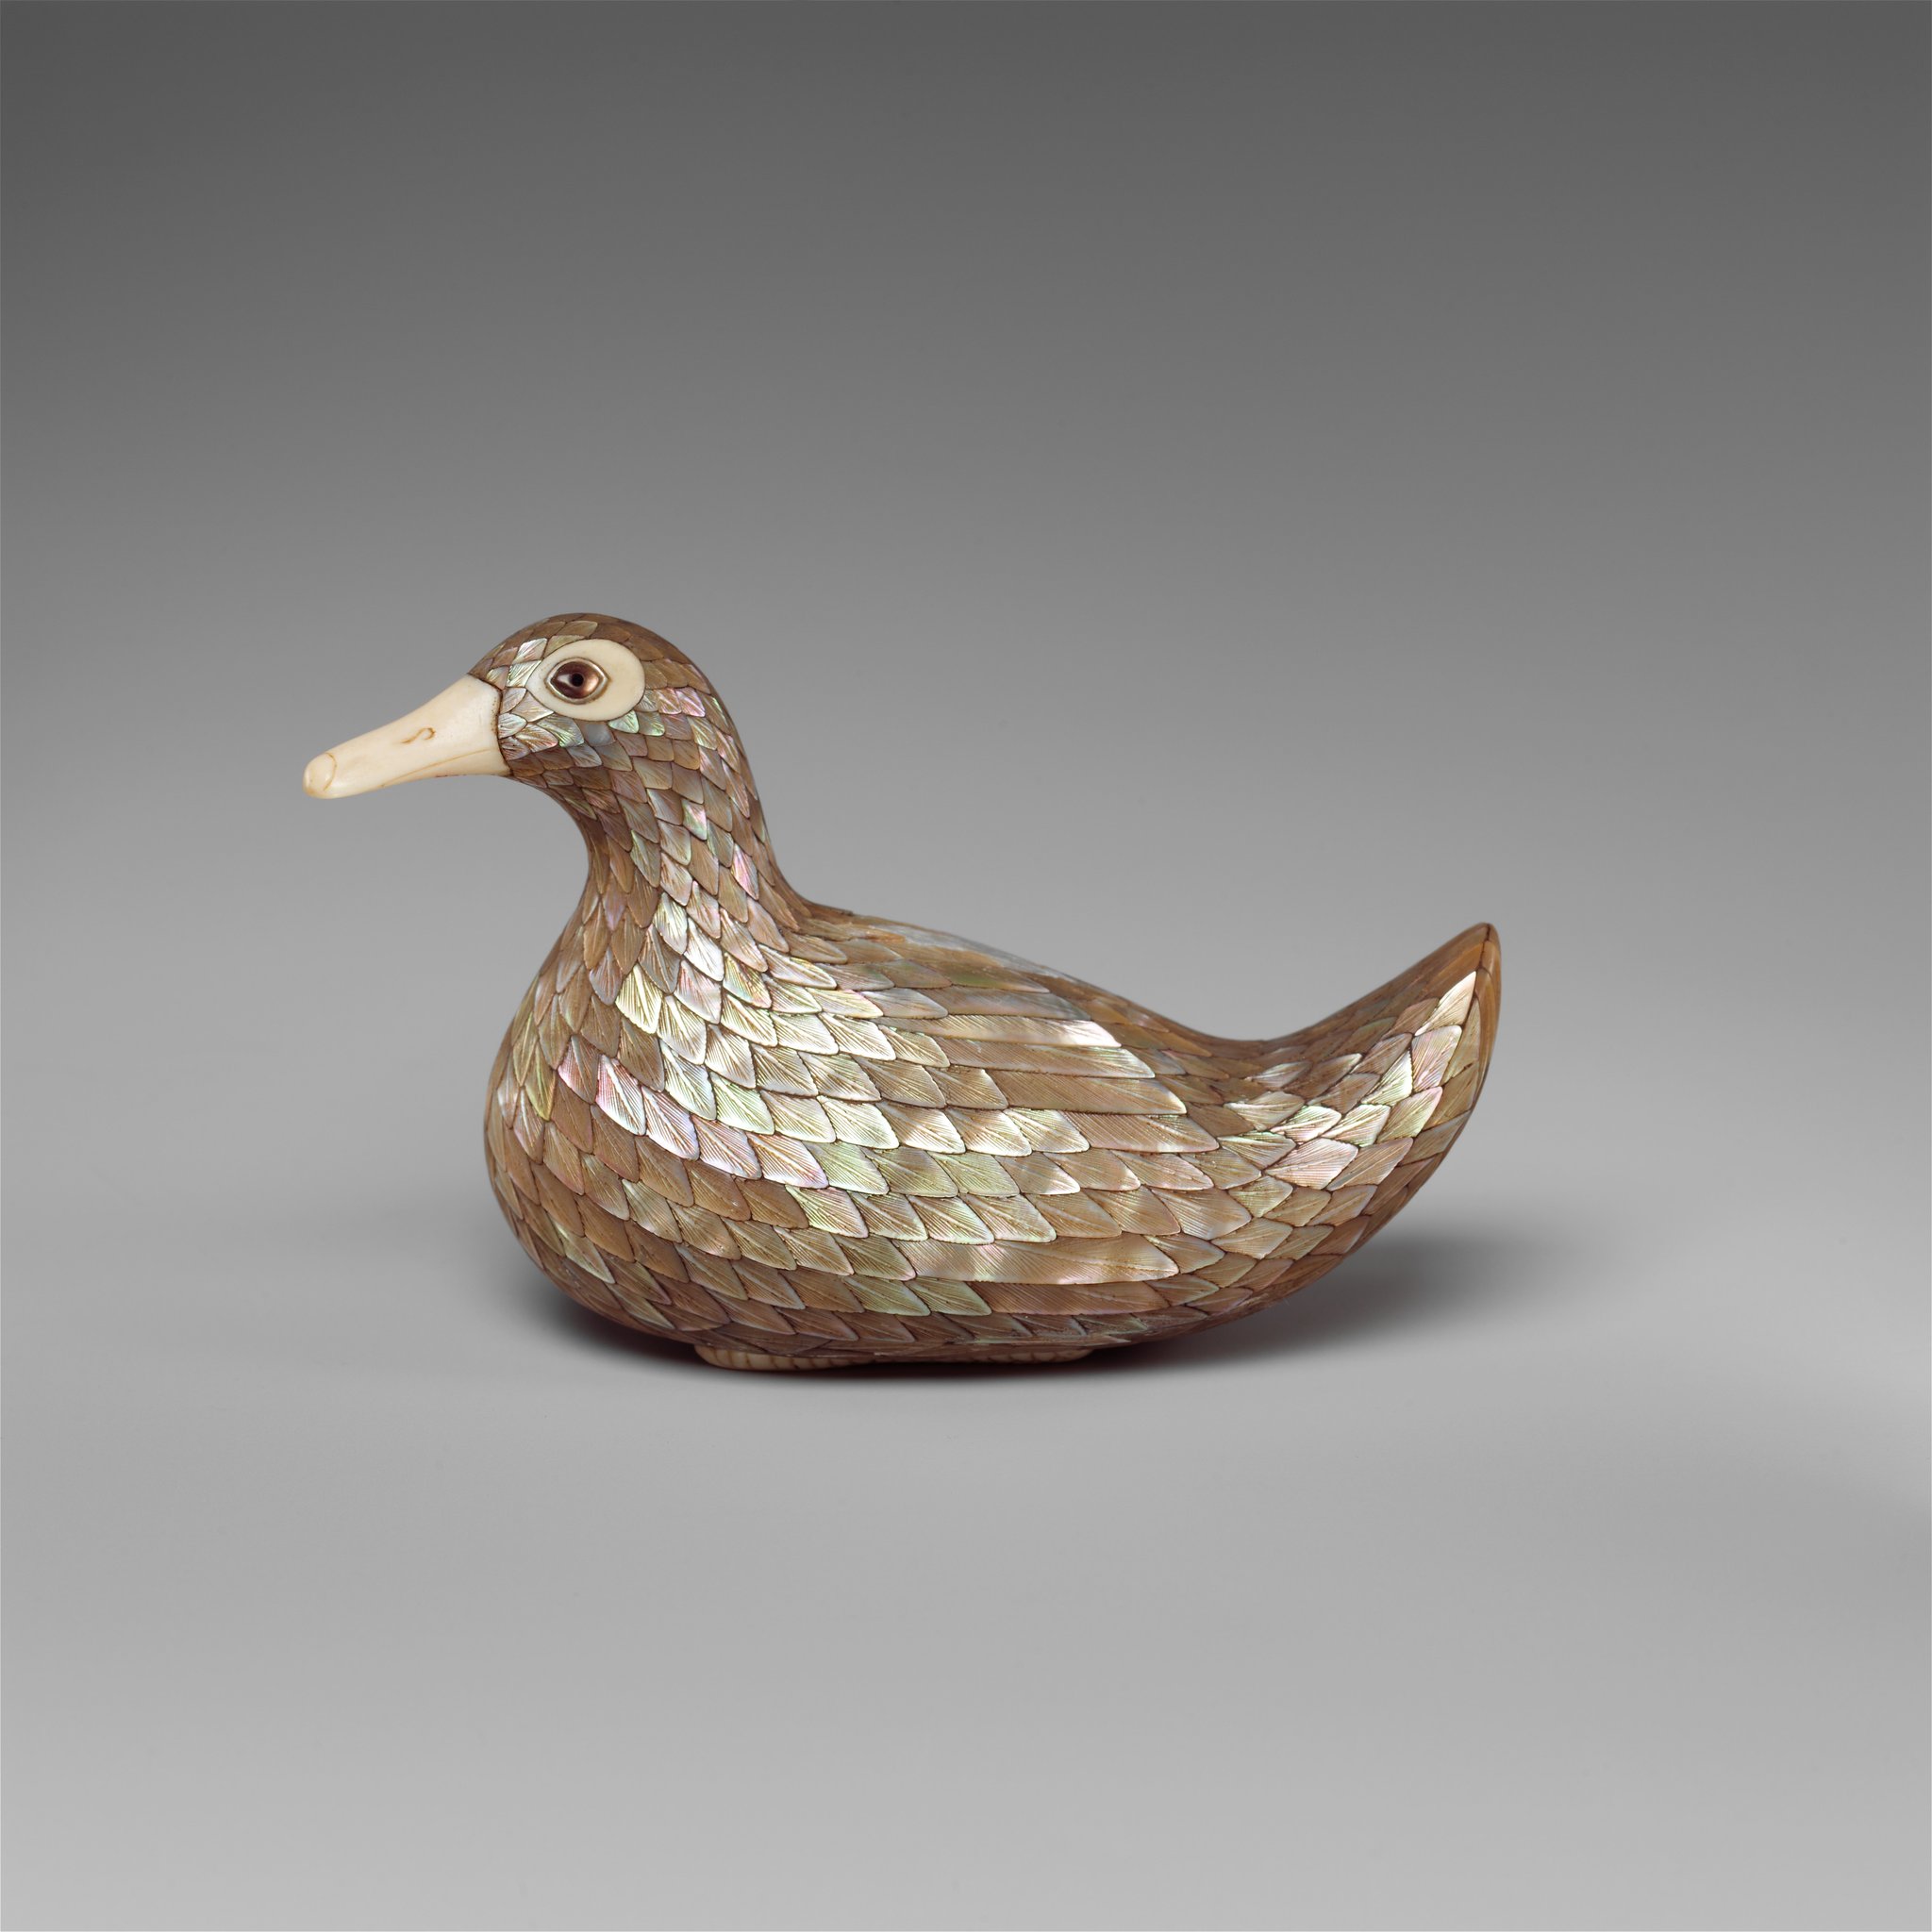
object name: box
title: One of a Pair of Boxes in the Shape of Ducks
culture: chinese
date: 1701-1800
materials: glass, ivory, mother of pearl, wood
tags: ducks